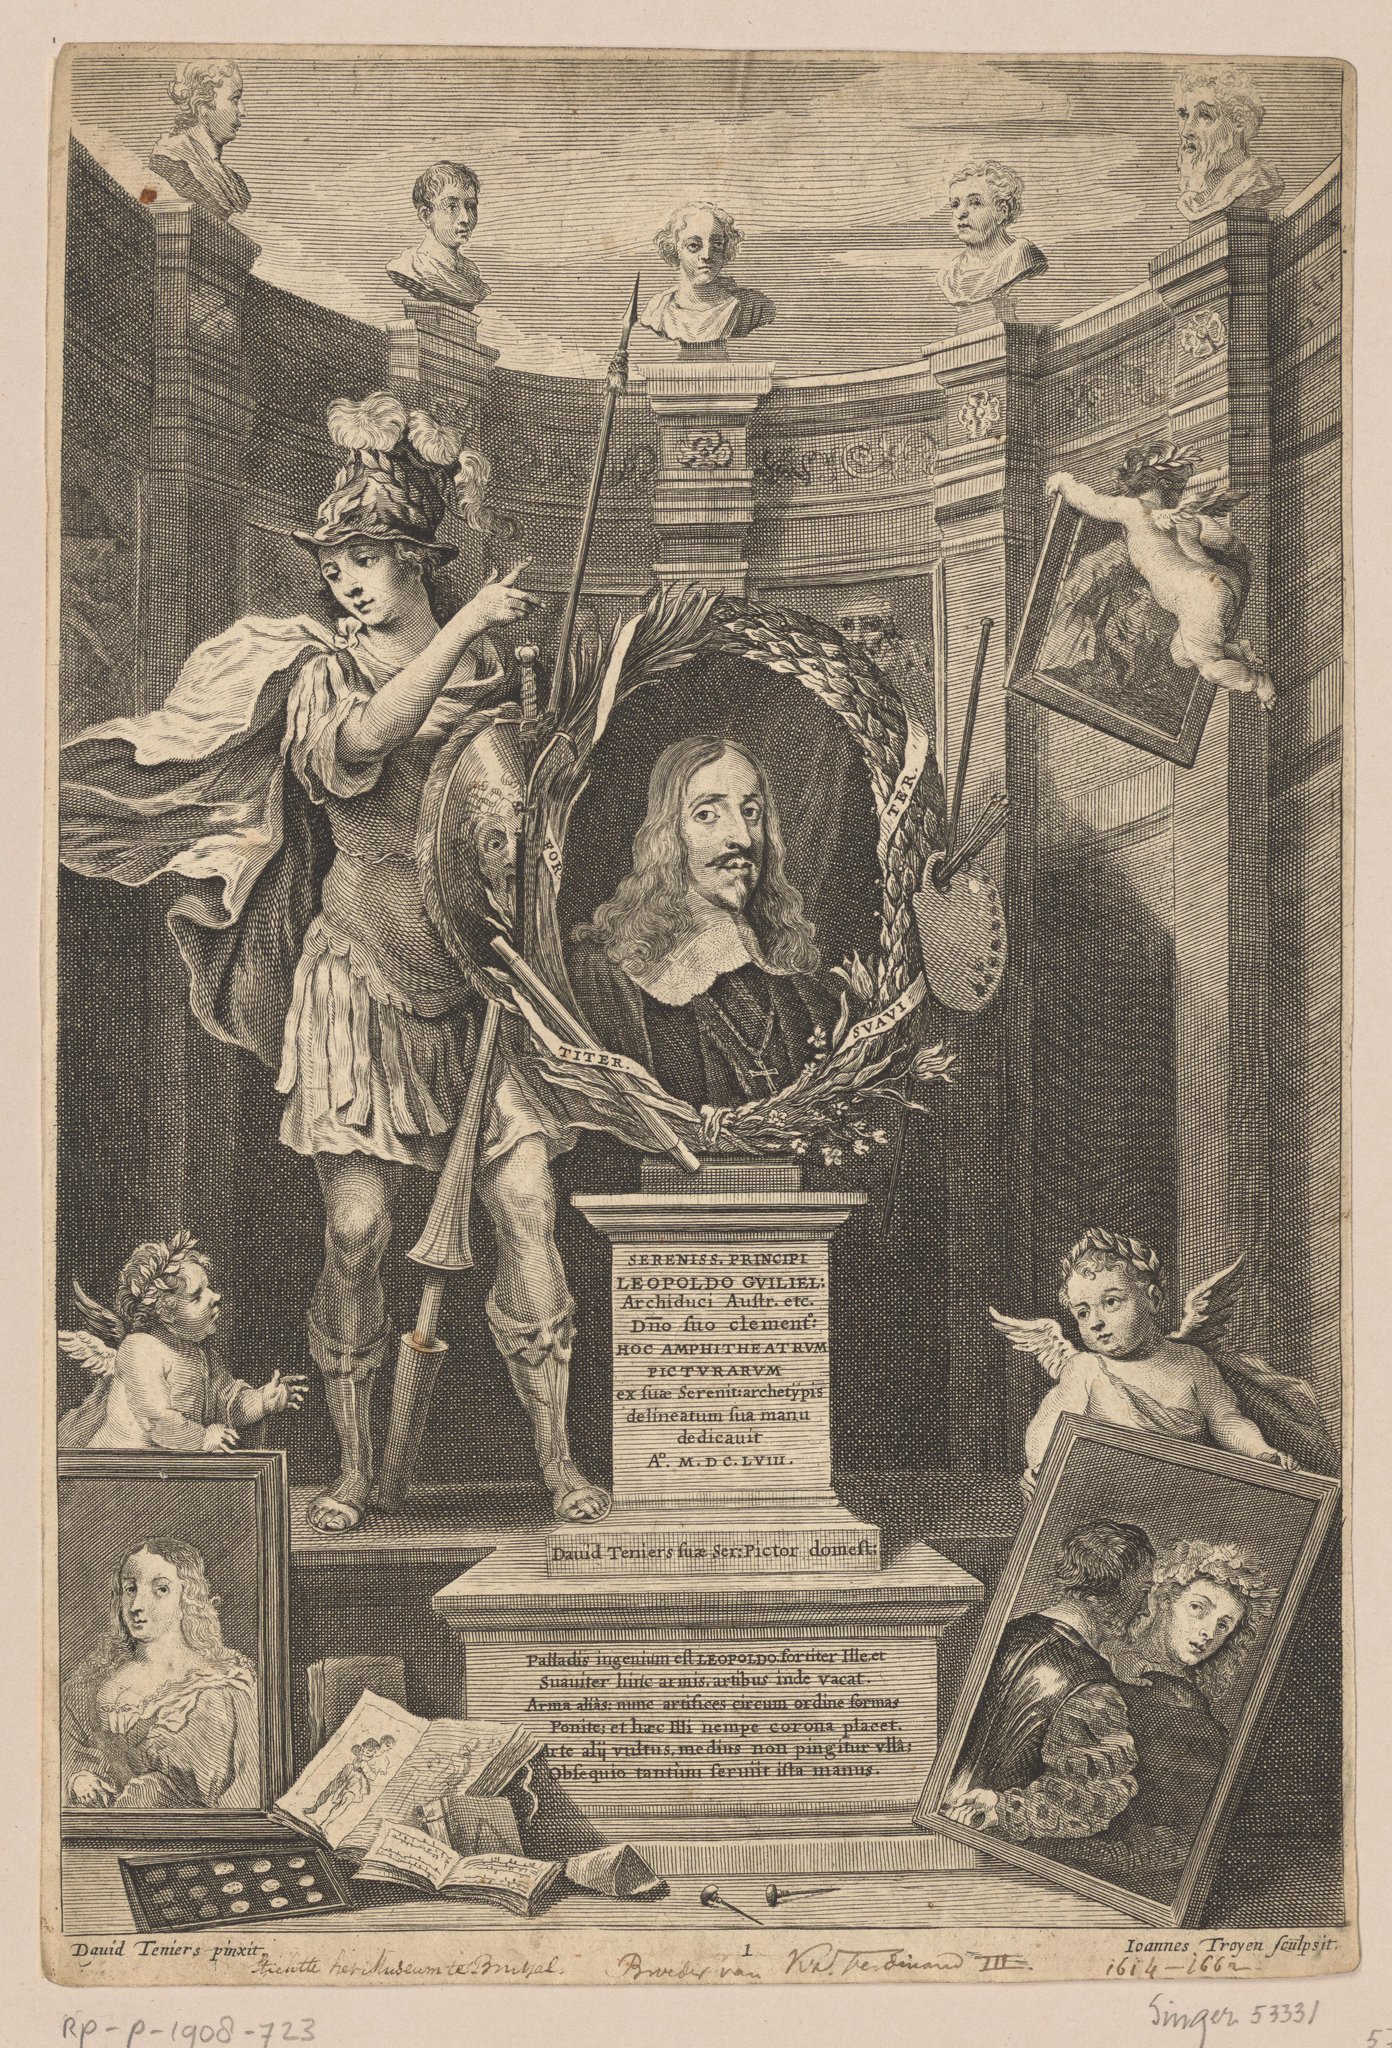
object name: titelprent, frontispice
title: Theater van schilderijen uit de collectie van Leopold Willem van Oostenrijk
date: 1658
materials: paper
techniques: engraving, etching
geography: brussels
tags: vienna, leopold willem van oostenrijk (landvoogd der zuidelijke nederlanden), minerva as patroness, historical persons, art collector, coin, palette, picture, painting, cupids: 'amores', 'amoretti', 'putti'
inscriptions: collector's mark: Lugt 2228, inscription: ‘Stichtte het Museum te Brussel. Broeder van Keiz. Ferdinand III. 1614-1662’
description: Portret van Leopold Willem, aartshertog van Oostenrijk en landvoogd van de Zuidelijke Nederlanden, in een ovale lijst met zijn motto, op een pedestal met een opdracht aan hem in het Latijn, en daaronder een zesregelig lofdicht in het Latijn. Naast zijn portret staat Minerva als beschermster van de kunsten. Naast het pedestal schilderijen uit de collectie van Leopold Willem. Linksonder een verzameling munten, een boek met tekeningen en een muziekboek. Op de achtergrond een klassiek gebouw met mannenbusten. Midden onder genummerd: 1.